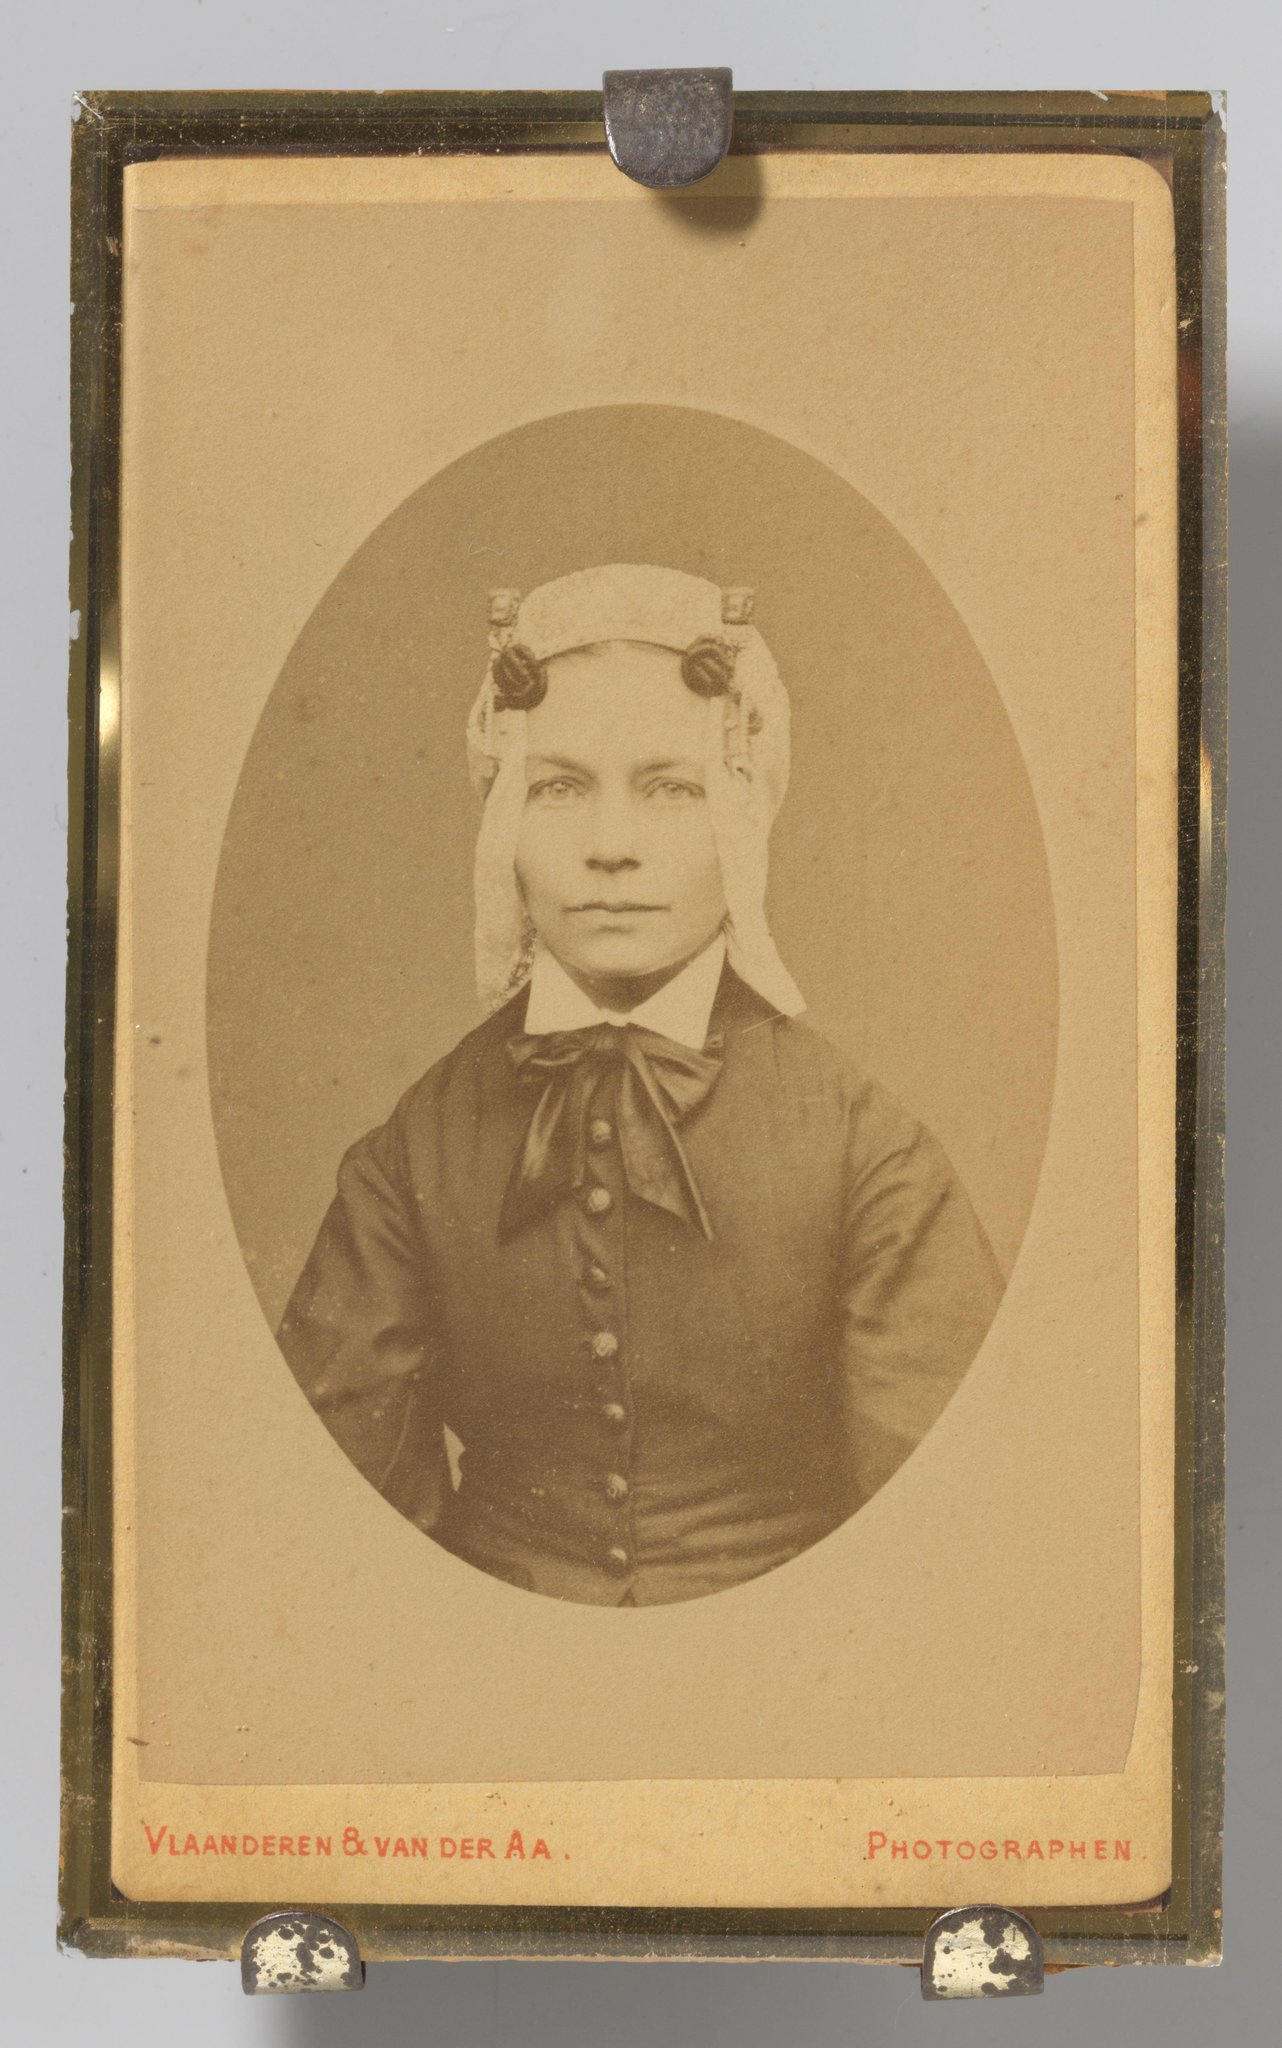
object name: photograph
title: Portret van een onbekende vrouw in klederdracht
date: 1878-1884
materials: cardboard, glass, metal, paper, wood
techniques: albumen print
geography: alkmaar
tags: adult woman, anonymous historical person portrayed, folk costume, regional costume, netherlands